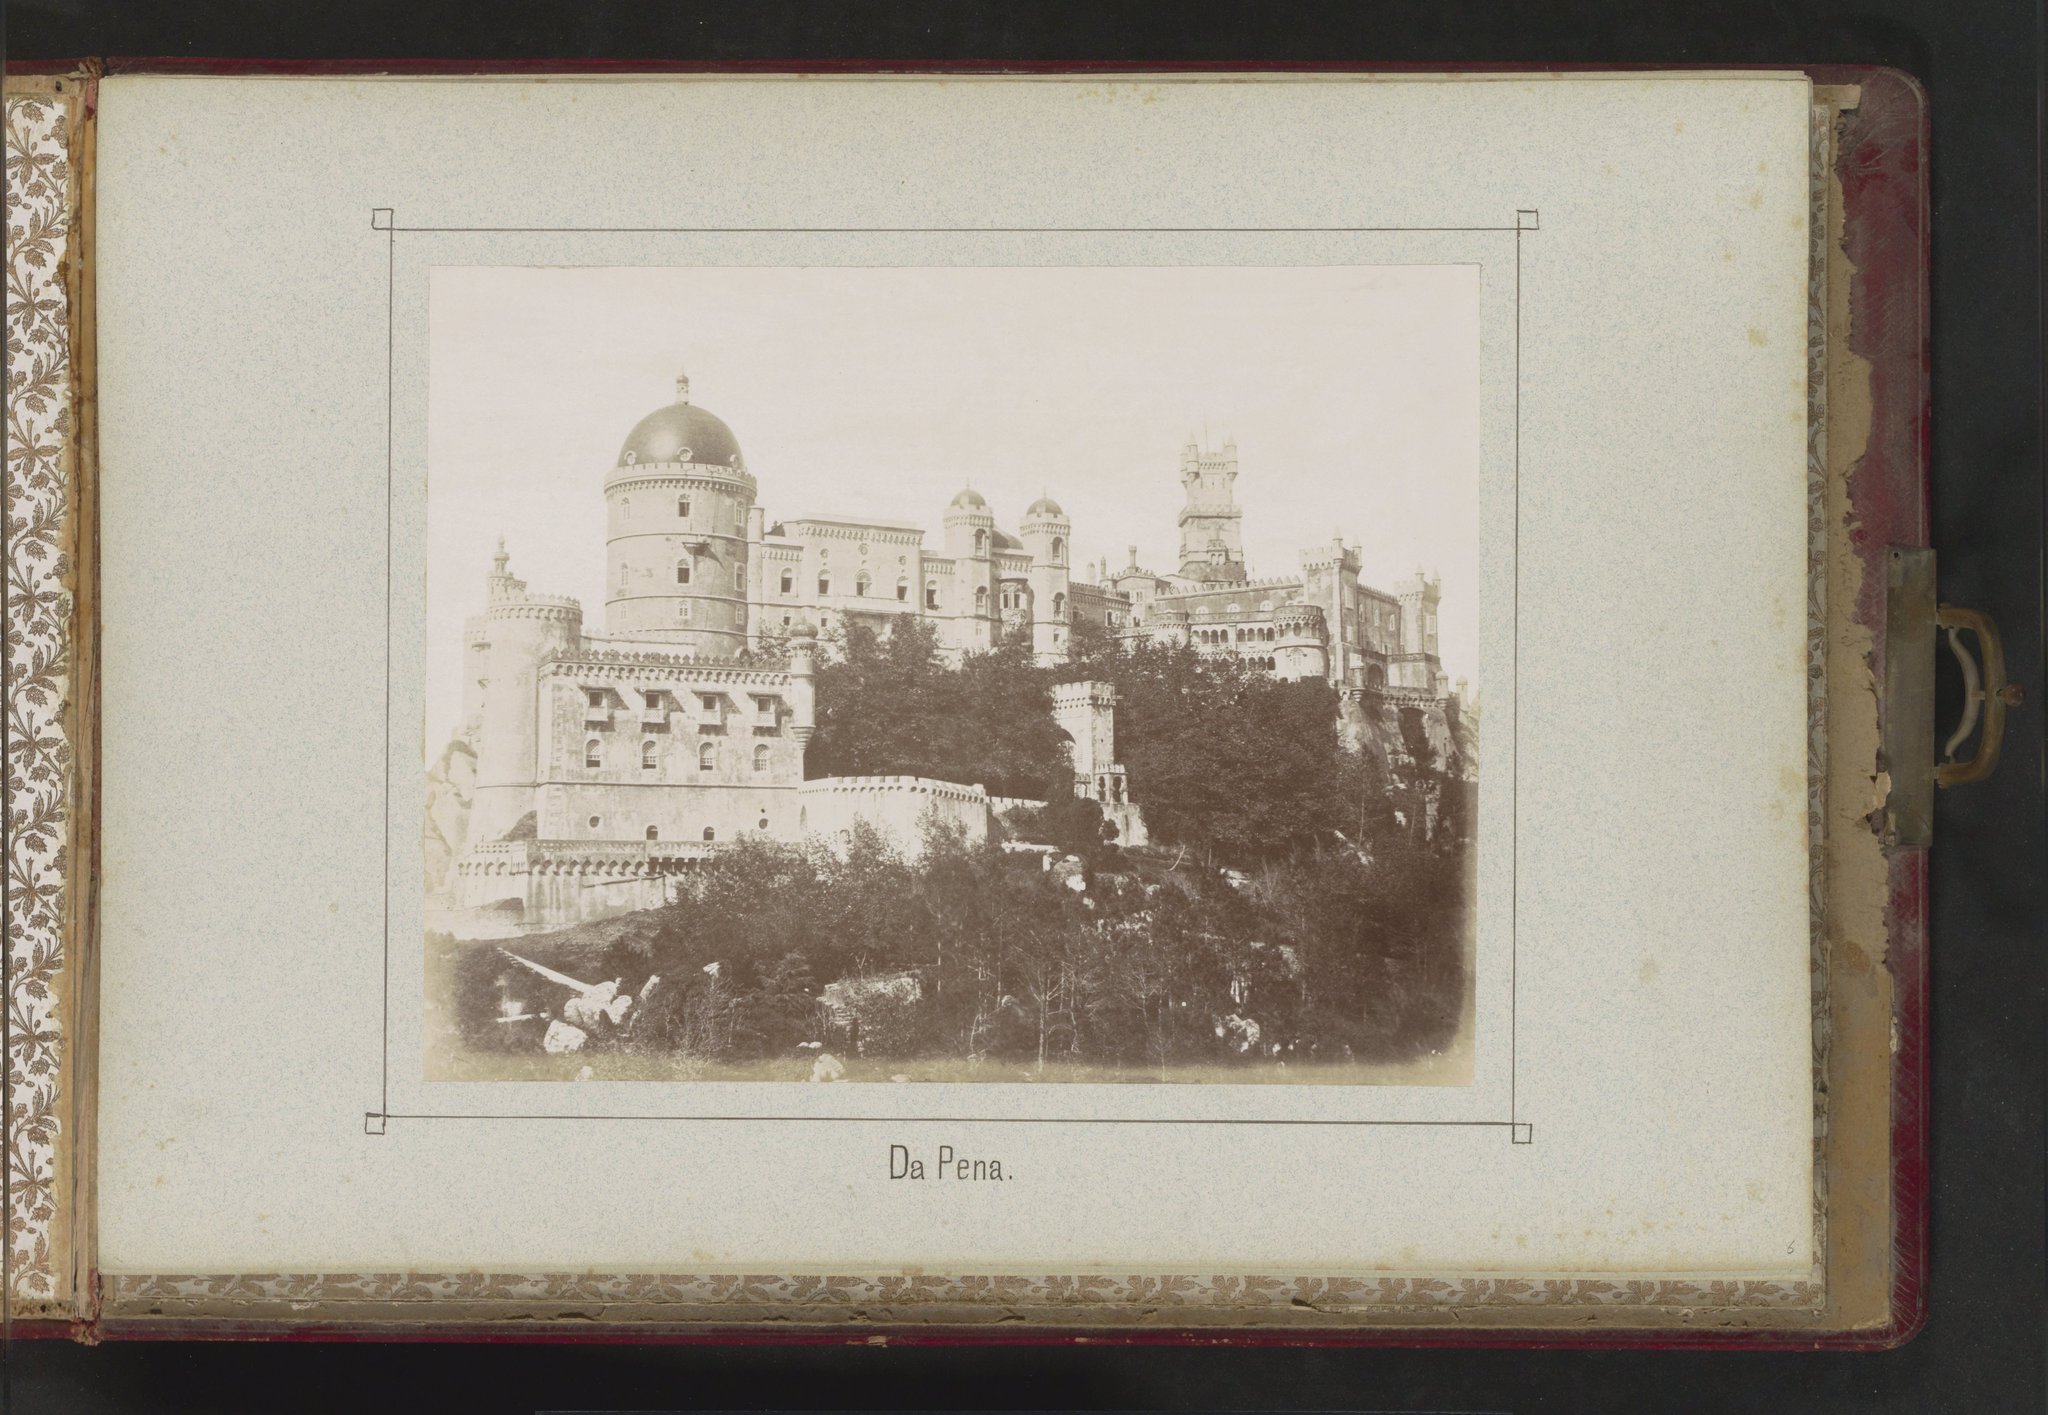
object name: photograph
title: Gezicht op het Paleis van Pena in Lissabon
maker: Anonymous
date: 1880-1900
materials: photographic support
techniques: albumen print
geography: lisbon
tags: palace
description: Onderdeel van Reisalbum met foto's van Zuid-Afrika, Madeira, Portugal, Frankrijk en Duitsland.